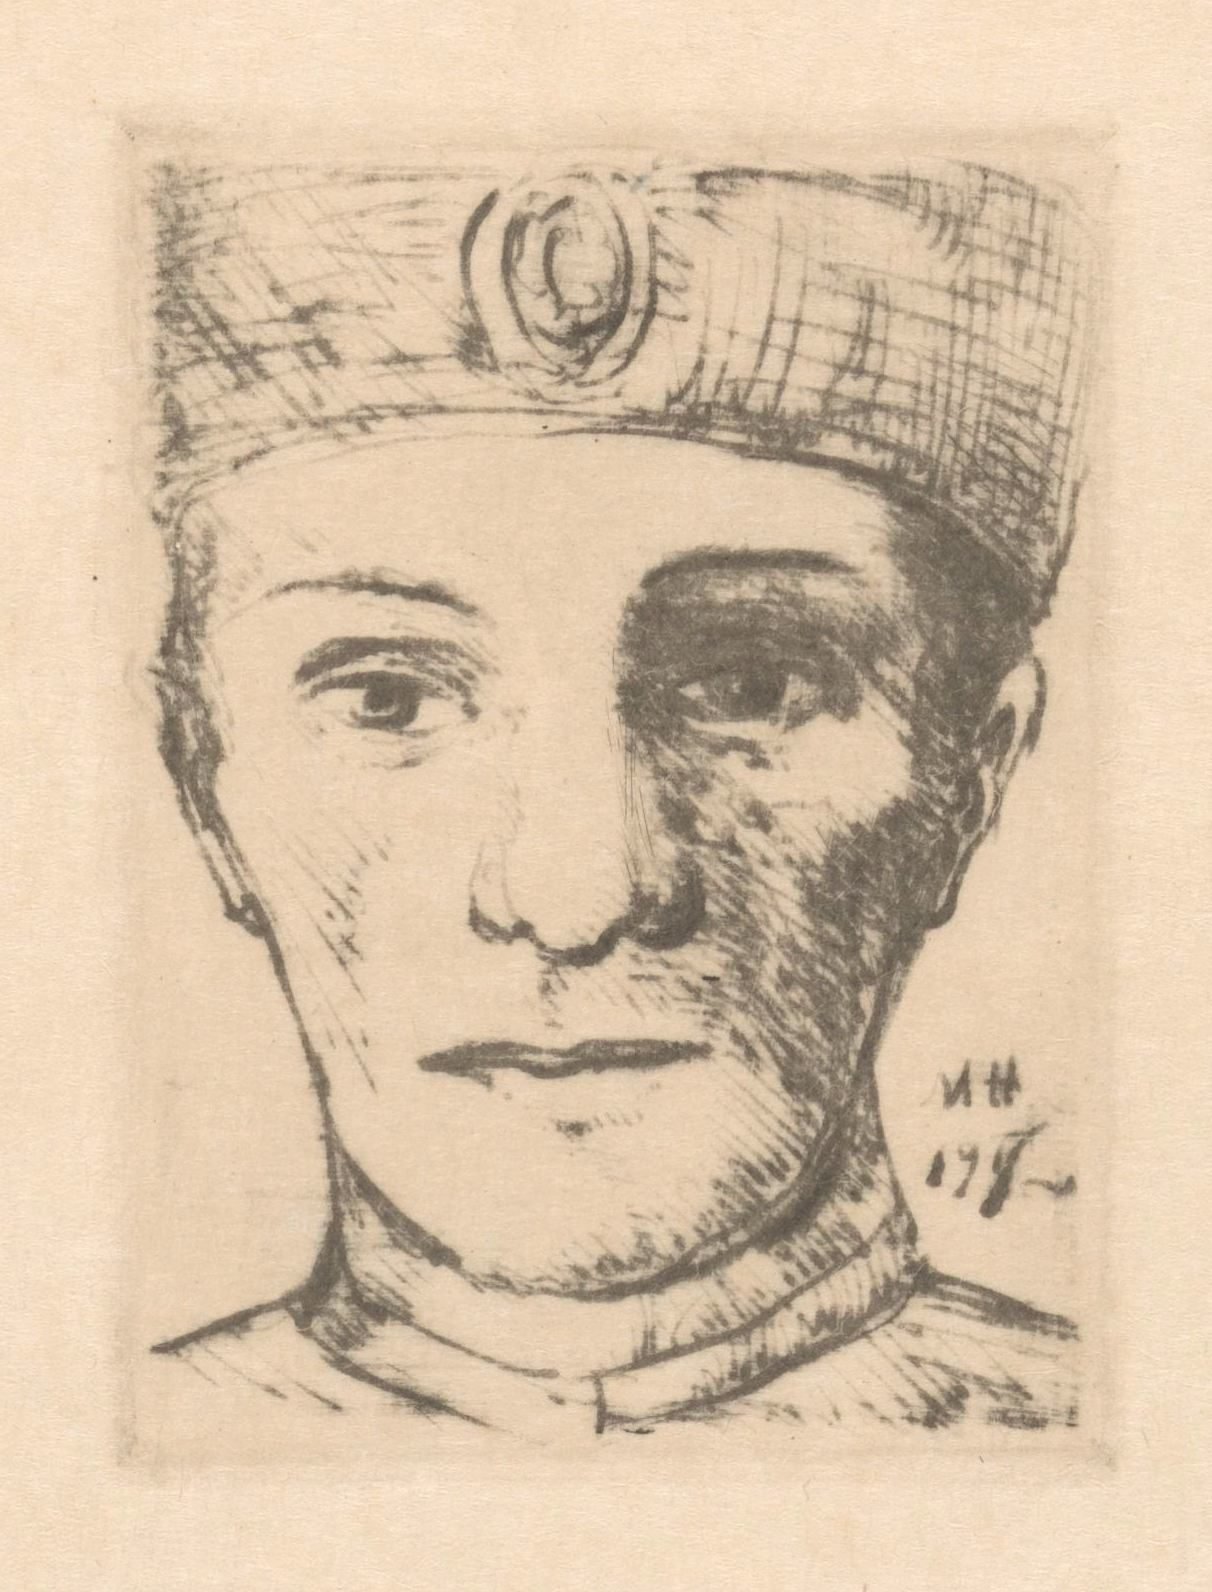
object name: print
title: Man met tulband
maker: marius holleman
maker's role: draughtsman, print maker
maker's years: 1878-1926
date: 1917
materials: paper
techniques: etching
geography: groningen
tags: head-gear: turban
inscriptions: collector's mark: Lugt 2228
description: Op de voorkant van de tulband een cirkel.